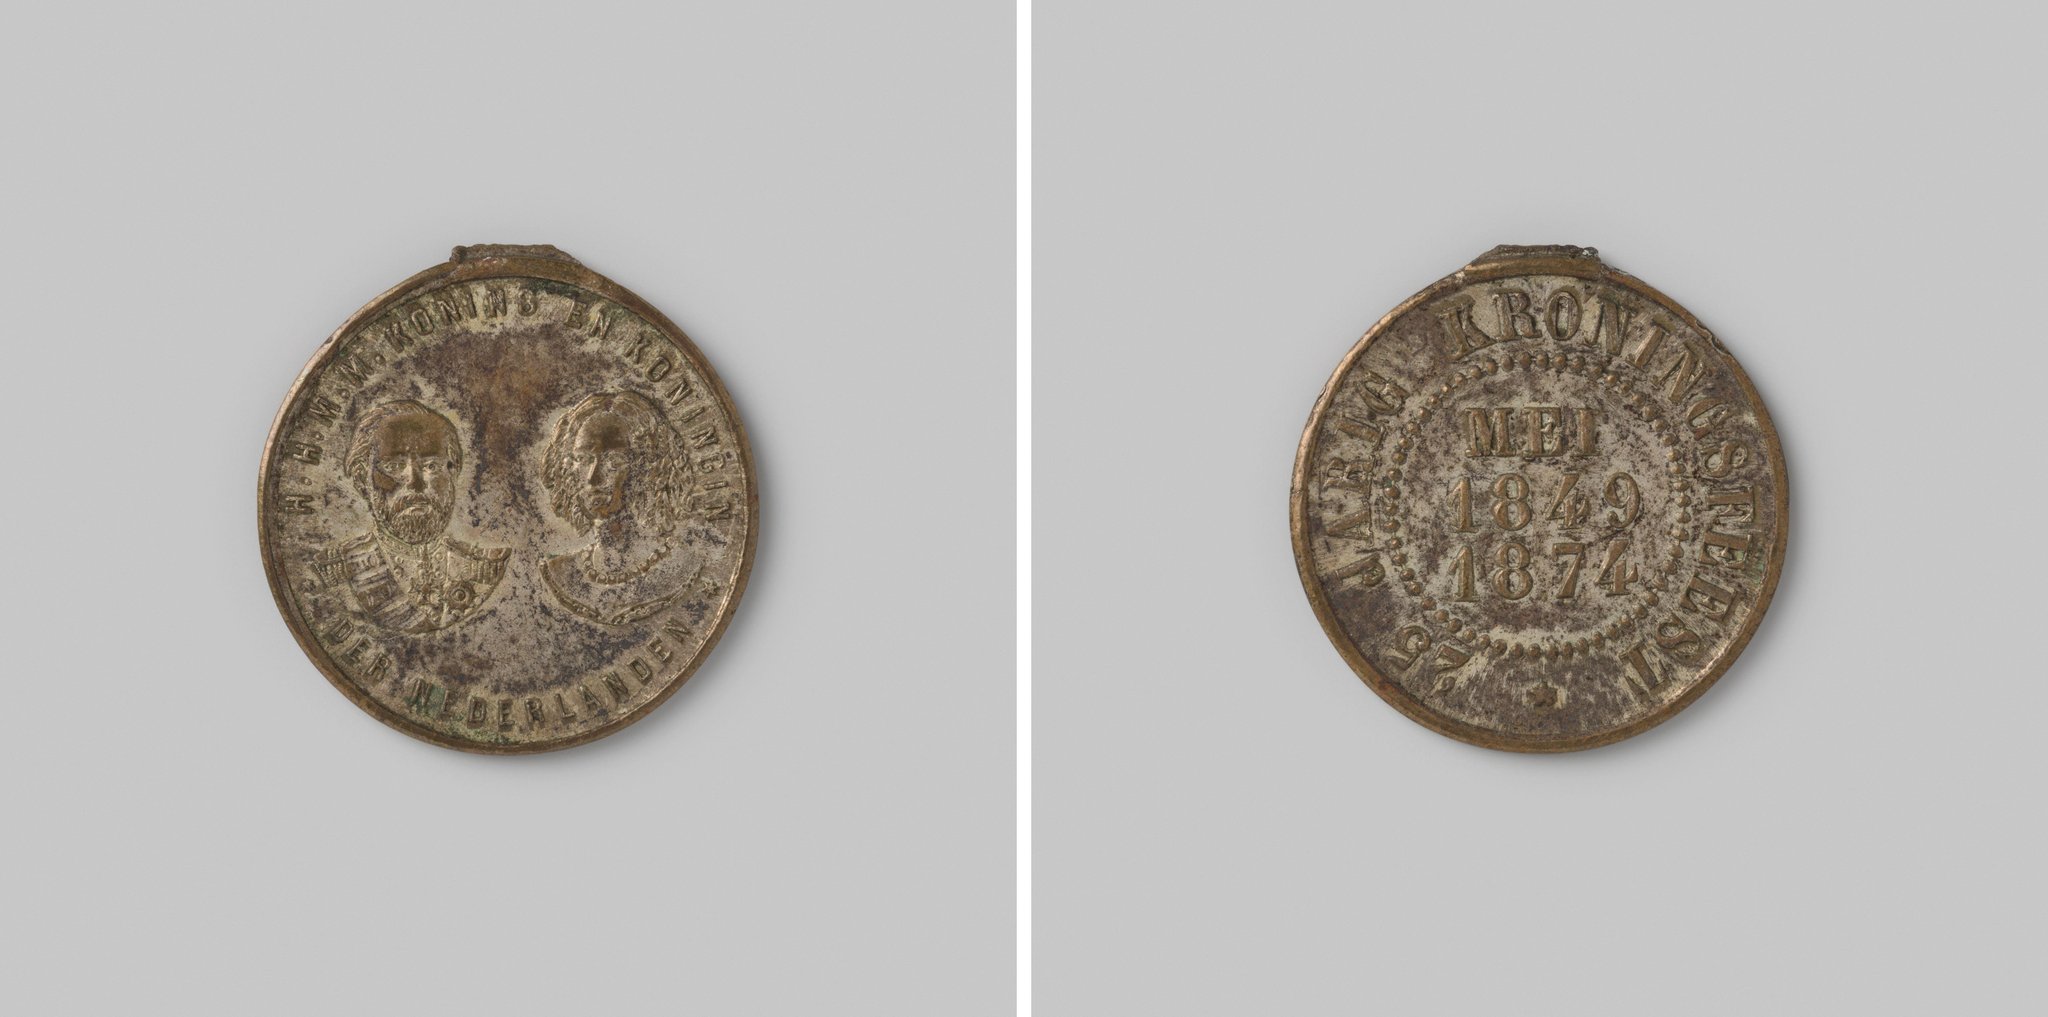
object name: insignia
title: Vijfentwintigjarig regeringsjubileum van Koning Willem III en Koningin Sophia 1874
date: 1874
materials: brass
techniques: striking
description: Medaillon verwijderd van een draaggesp van verzilverd messing, met op de voorzijde de aanziende portretten van Willem III en Sophia met omschrift, op de keerzijde drie regels tekst met omschrift.